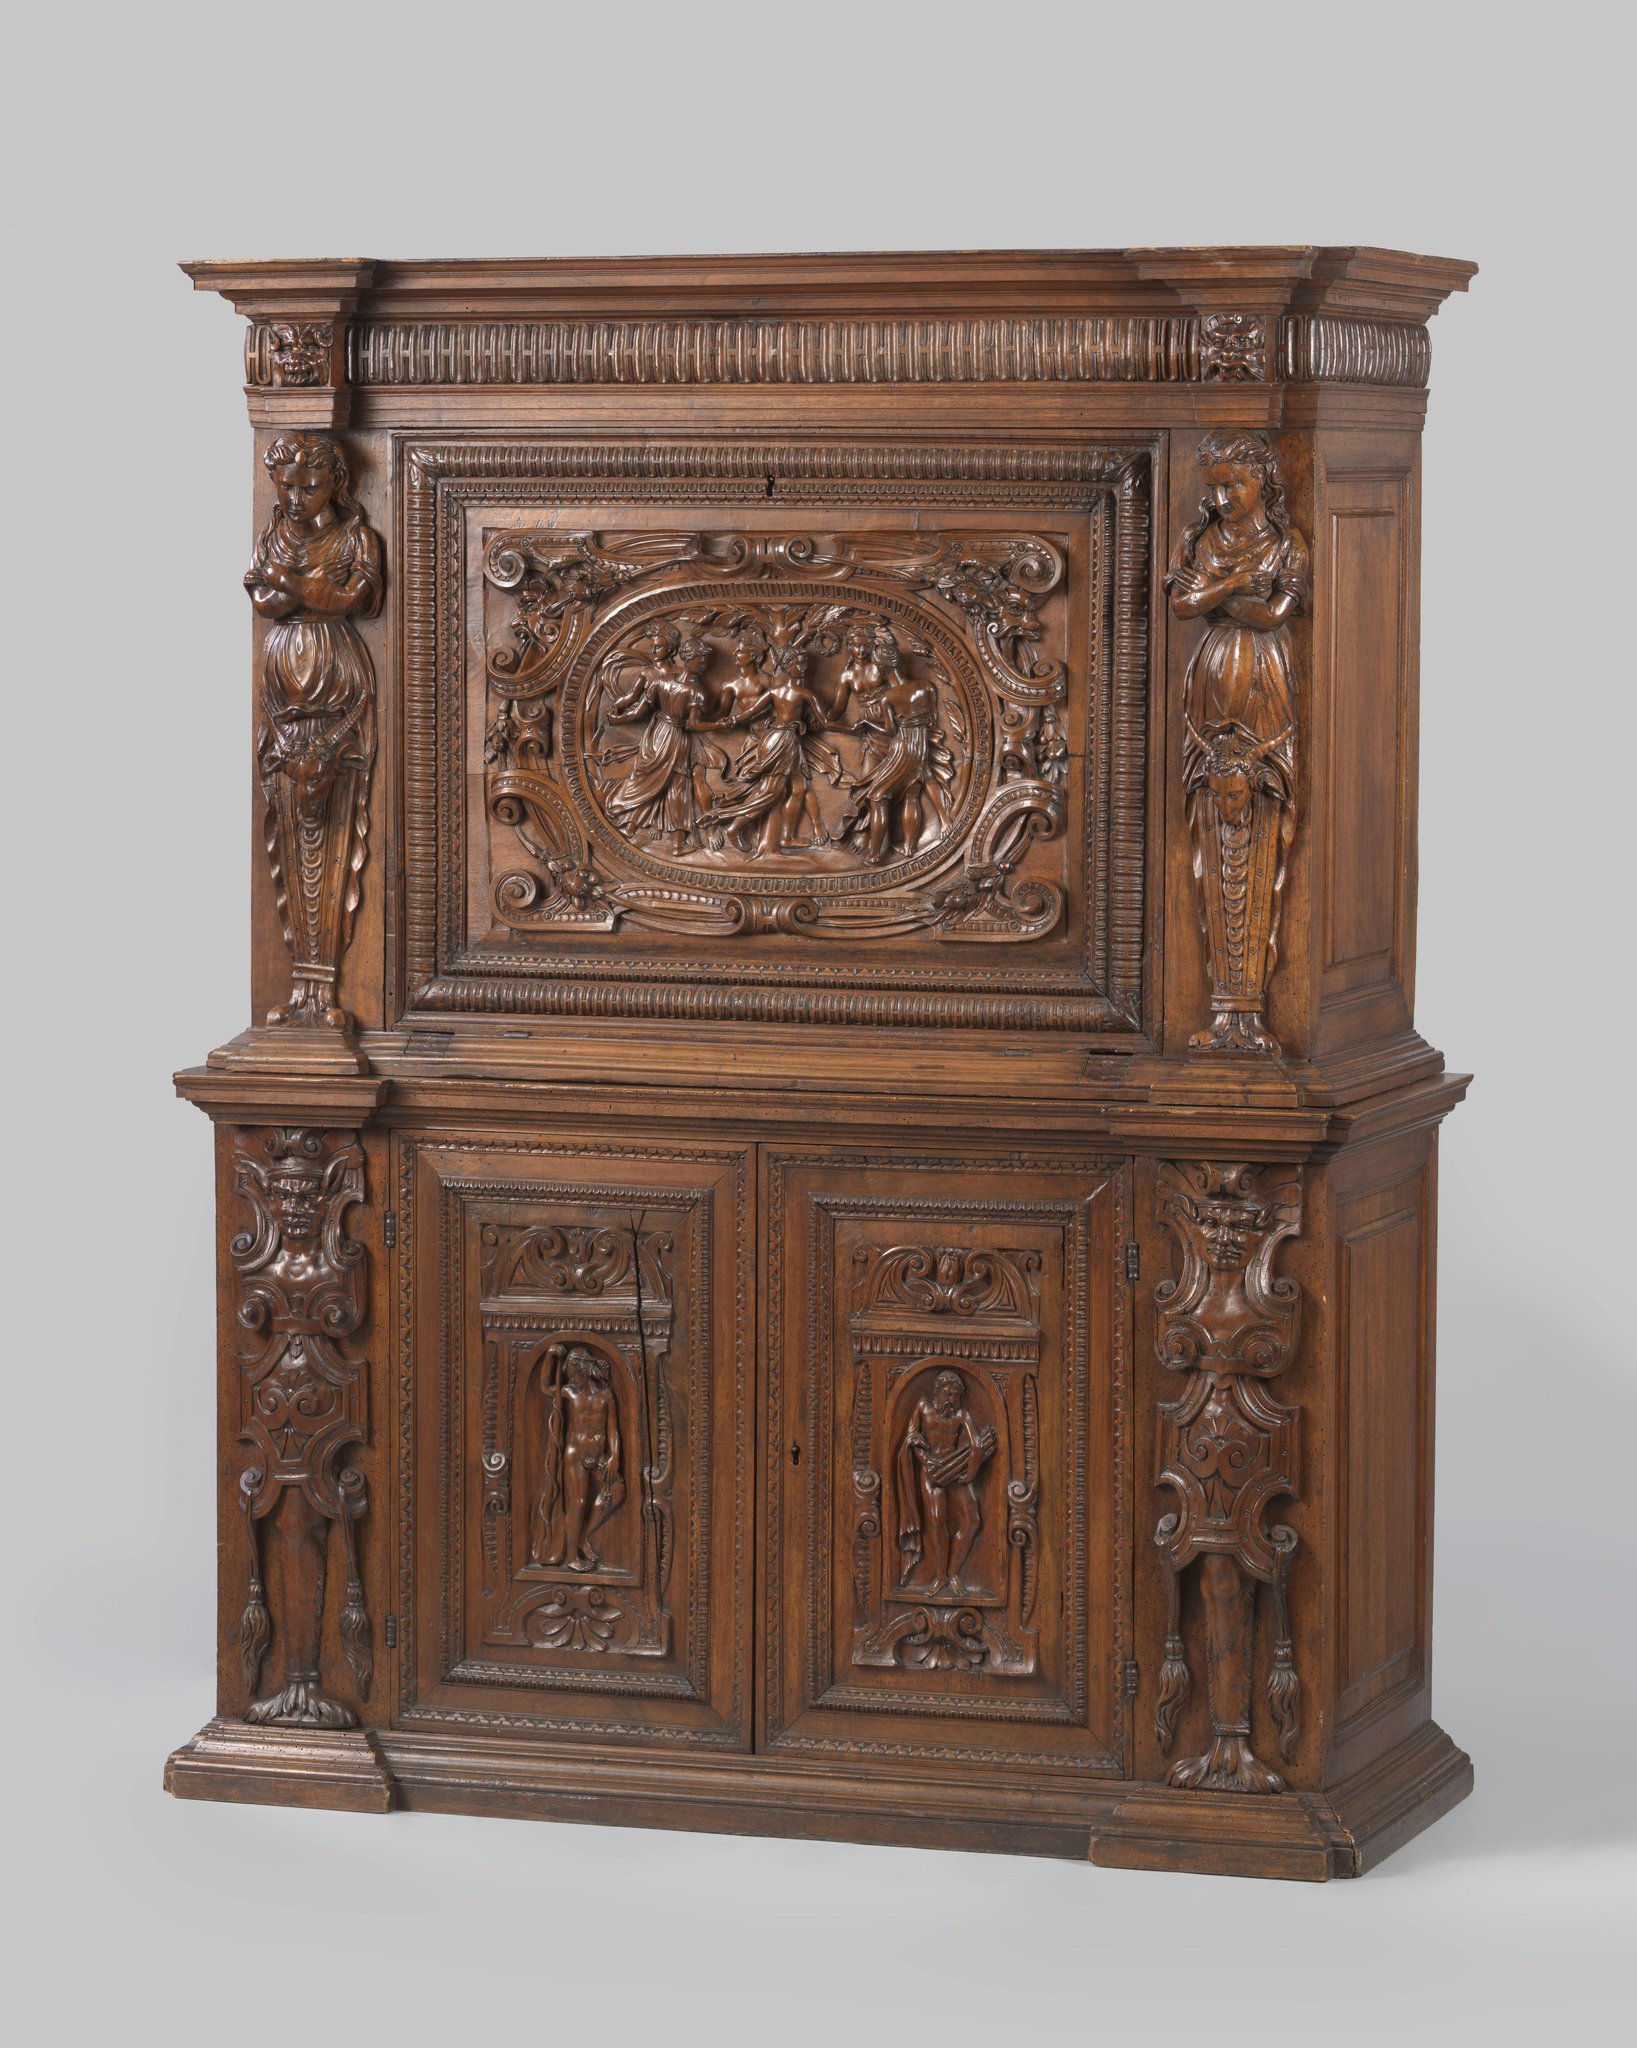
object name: desk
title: Schrijfkast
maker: Anonymous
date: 1550-1600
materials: bronze, wood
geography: northern italy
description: Schrijfkast van notenhout, verdeeld in onder- en bovenkast. De bovenkast heeft op de hoekstijlen gebeeldhouwde hermcaryatiden. Het middenveld, te gebruiken als schrijfblad, toont ovaal reliëf waarop zes dansende meisjes rond een boom. Het fries is versierd met schalmen en maskers. De onderkast heeft op de hoekstijlen hermatlanten en twee deuren, in reliëf versierd met figuren die de Herfst en de Winter symboliseren. De zijkanten vertonen gladde panelen. De reliëfs zijn omgeven door rolwerk.